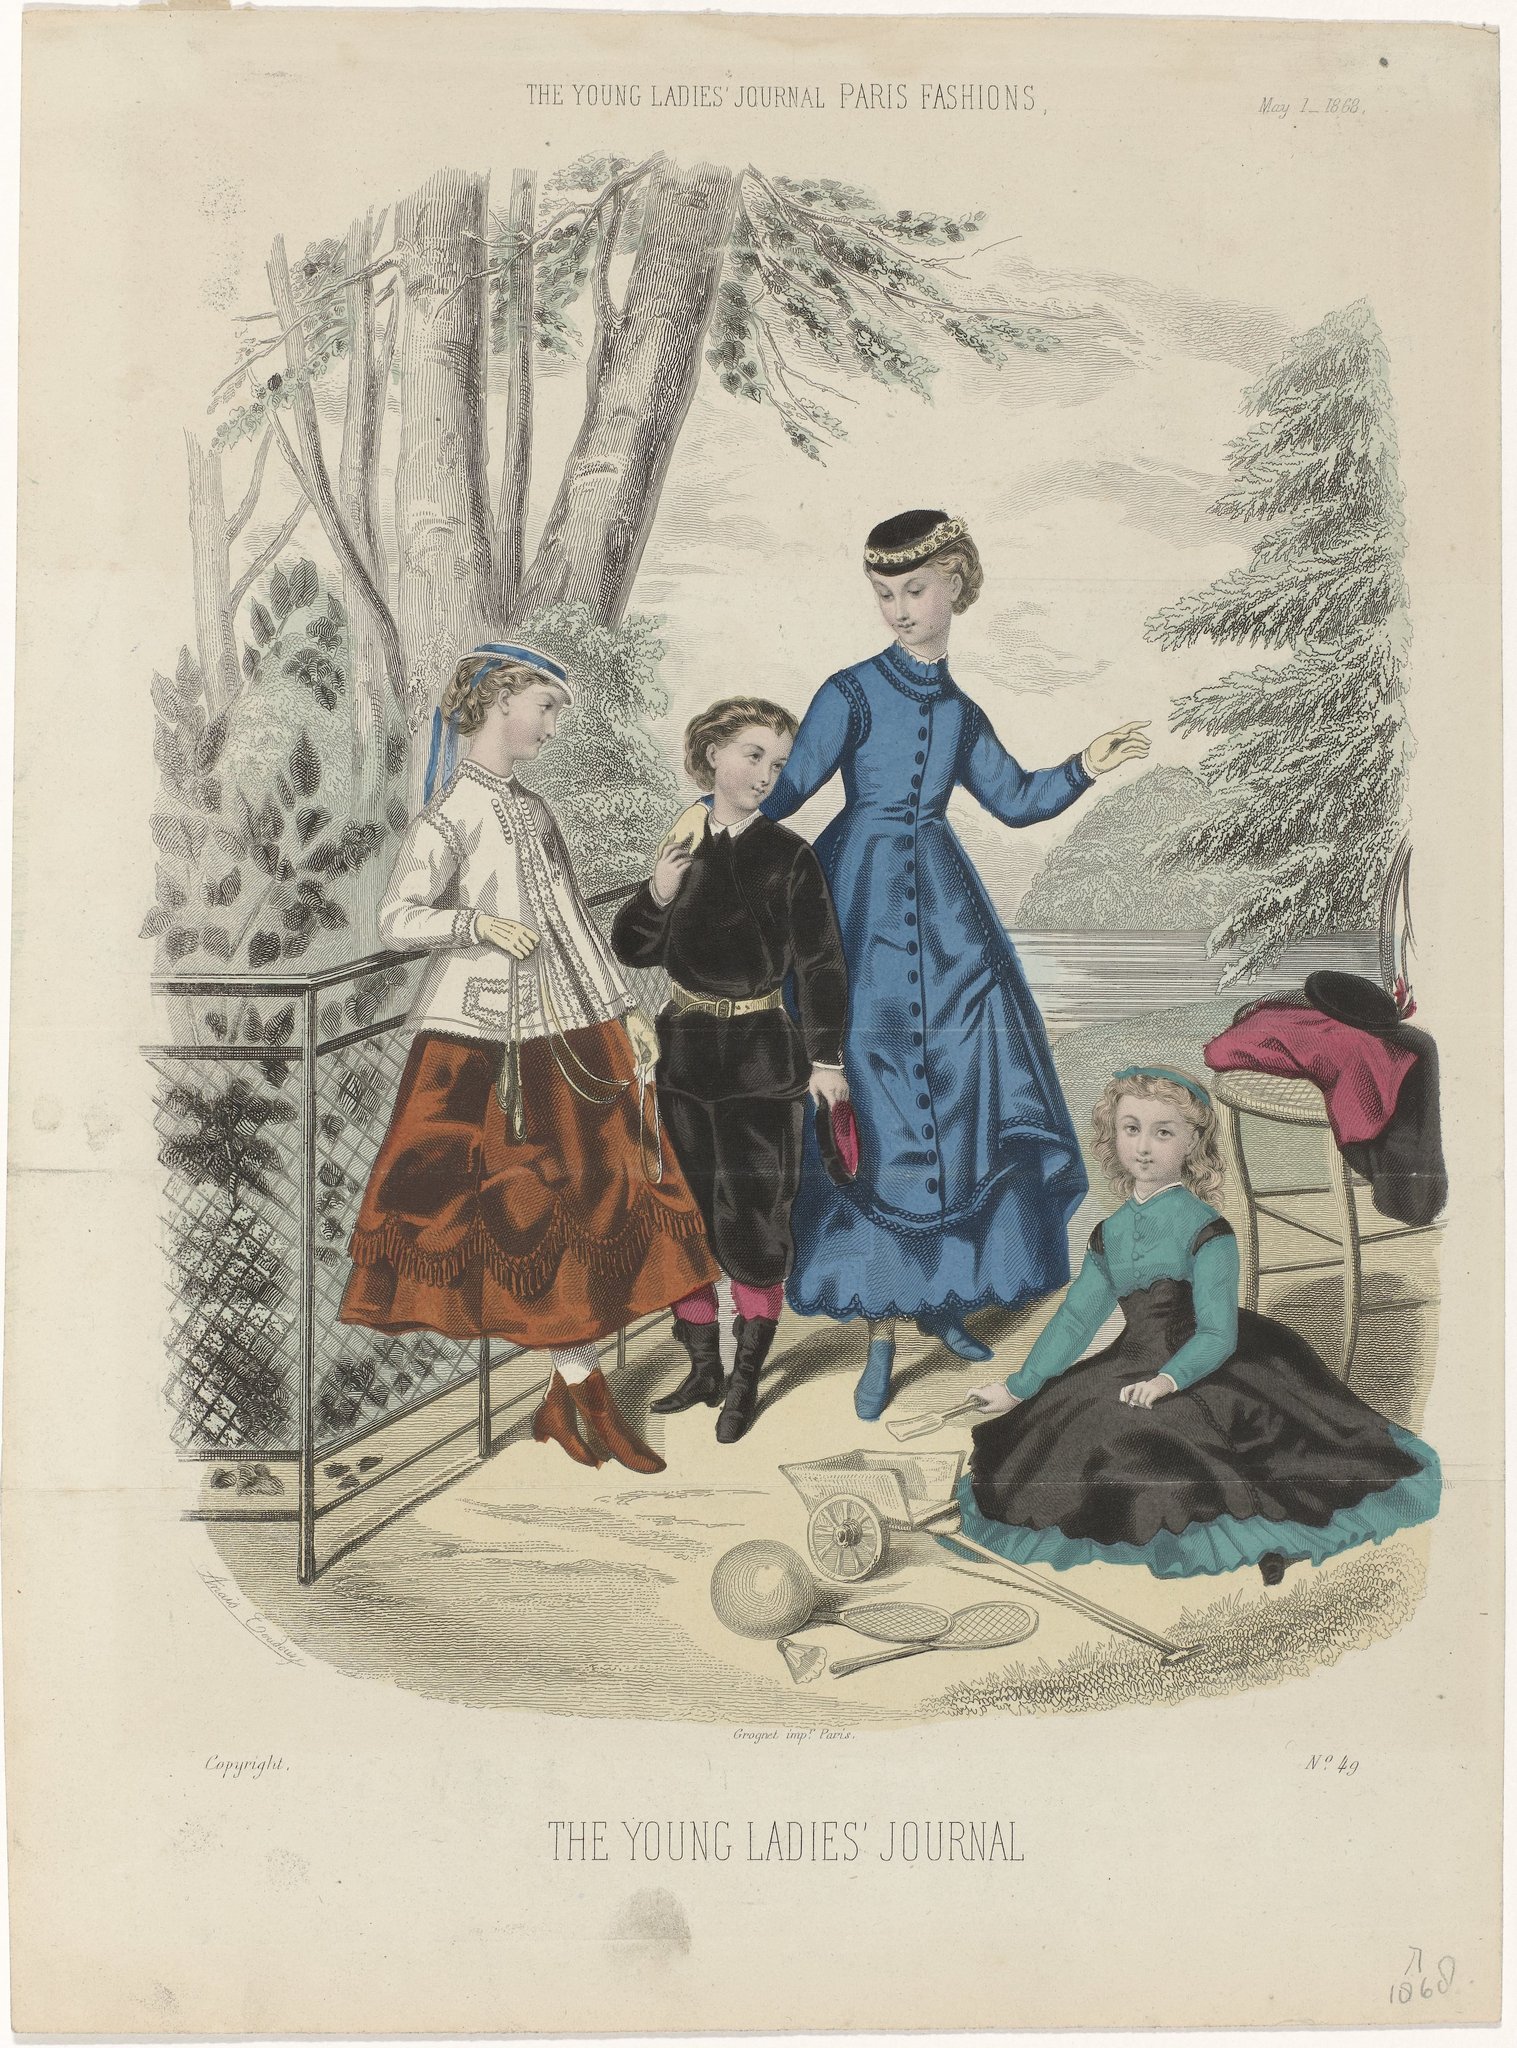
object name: fashion print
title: The Young Ladies' Journal, 1 May 1868, No. 49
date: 1868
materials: paper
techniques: engraving, hand coloring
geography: paris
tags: skirt (+ girls' clothes), head-gear: hat (+ girls' clothes), trousers, breeches (+ boys' clothes), clothing for the upper part of the body (+ boys' clothes), 'jeu de volant', badminton (+ equipment, outfit (sports, games, etc.)), diadem, tiara (+ girls' clothes), belt, girdle, waistband (+ boys' clothes), jumping-rope games (+ equipment, outfit (sports, games, etc.)), coat (+ girls' clothes), fence, wall, paling, fashion plates, (playing with) barrow, wagon, dress, gown (+ girls' clothes)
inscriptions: title: ‘THE YOUNG LADIES JOURNAL PARIS FASHIONS’, title: ‘THE YOUNG LADIES´JOURNAL’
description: Kinderkleding: drie meisje en jongen. Één meisje heeft een springtouw in de handen. Op de voorgrond ligt speelgoed: schepje, trekkar, bal, badmintonrackets en shuttle. Prent uit het modetijdschrift The Young Ladies' Journal (Londen 1864-1920).